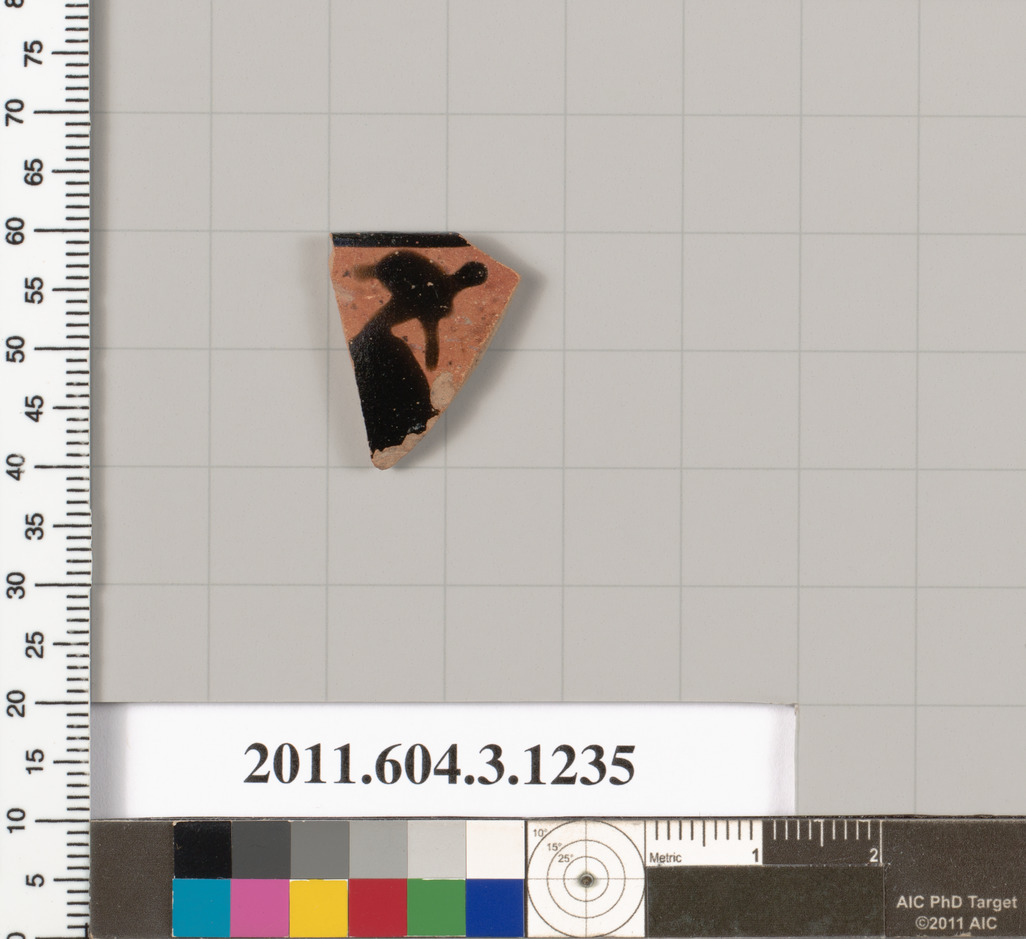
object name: kyathos fragment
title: Terracotta rim fragment of a kyathos (cup-shaped ladle)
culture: greek, attic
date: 534-468 BCE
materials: terracotta